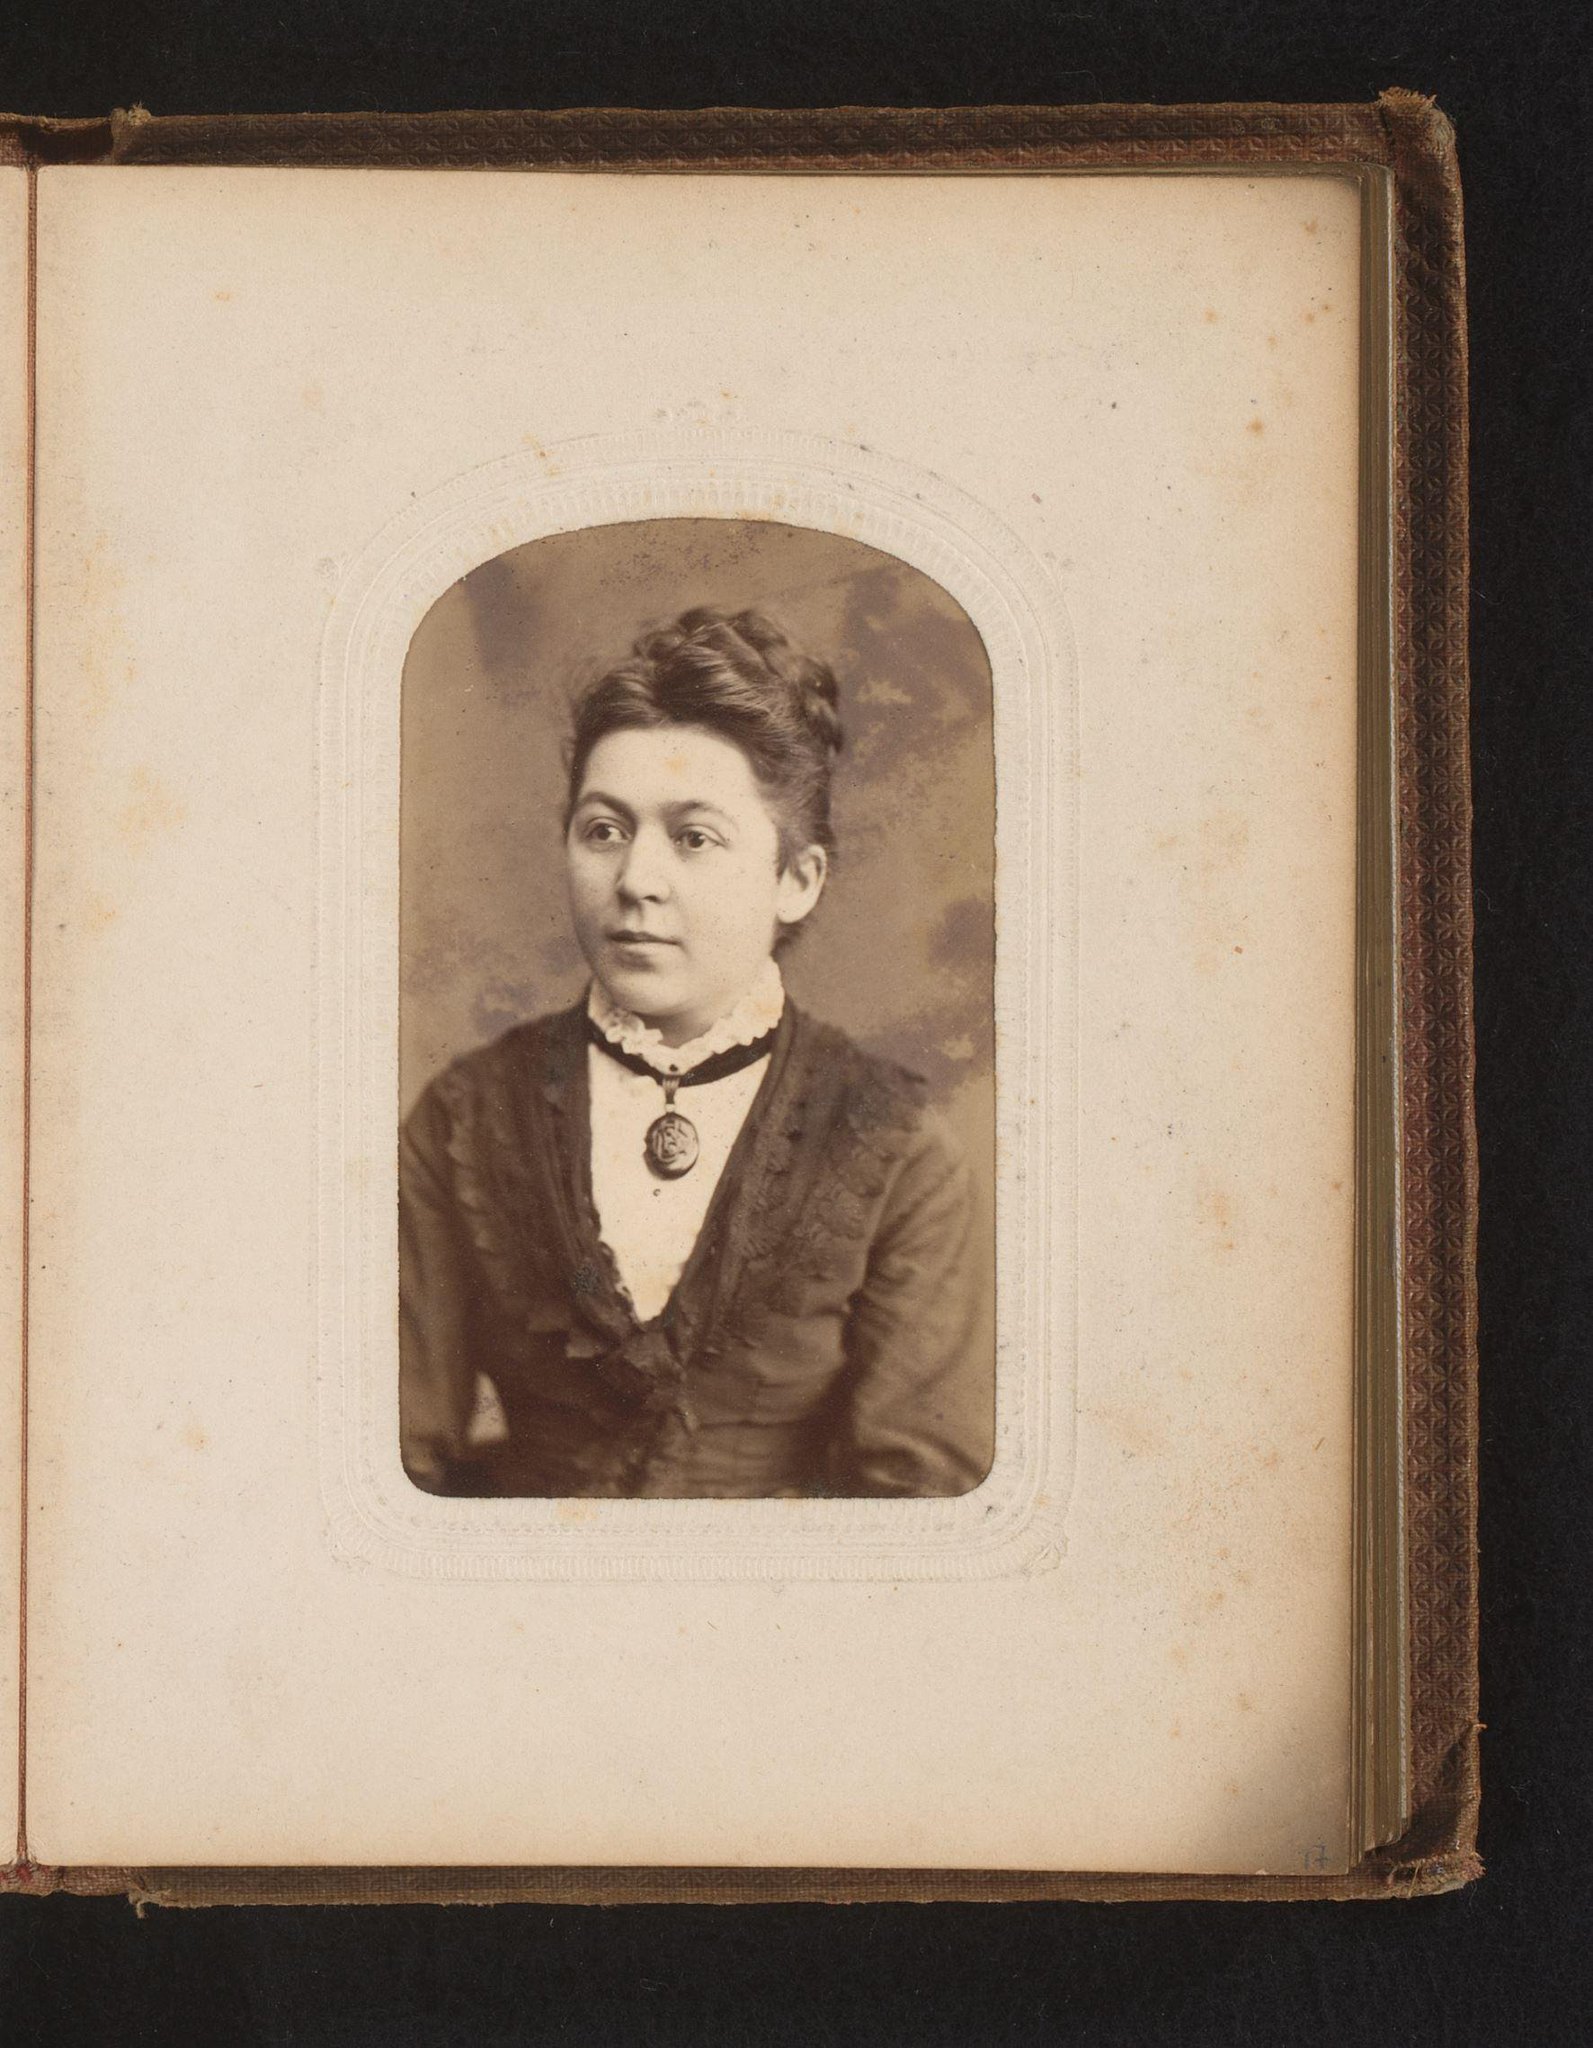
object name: album leaf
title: Portret van een vrouw met halsketting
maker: herrmann maas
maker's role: fotograaf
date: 1860-1900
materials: cardboard, photographic support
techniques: albumen print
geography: frankfurt am main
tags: historical persons - bb - woman, necklace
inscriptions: inscription: ‘Photograph:/ ATELIER/ HERRMANN MAAS/ (F.W. MAAS, SOHN)/ 18. Brönner Str. 18./ FRANKFURT a/M./ Für Nachbestellungen bleibt die Platte/ aufbewahrt.’